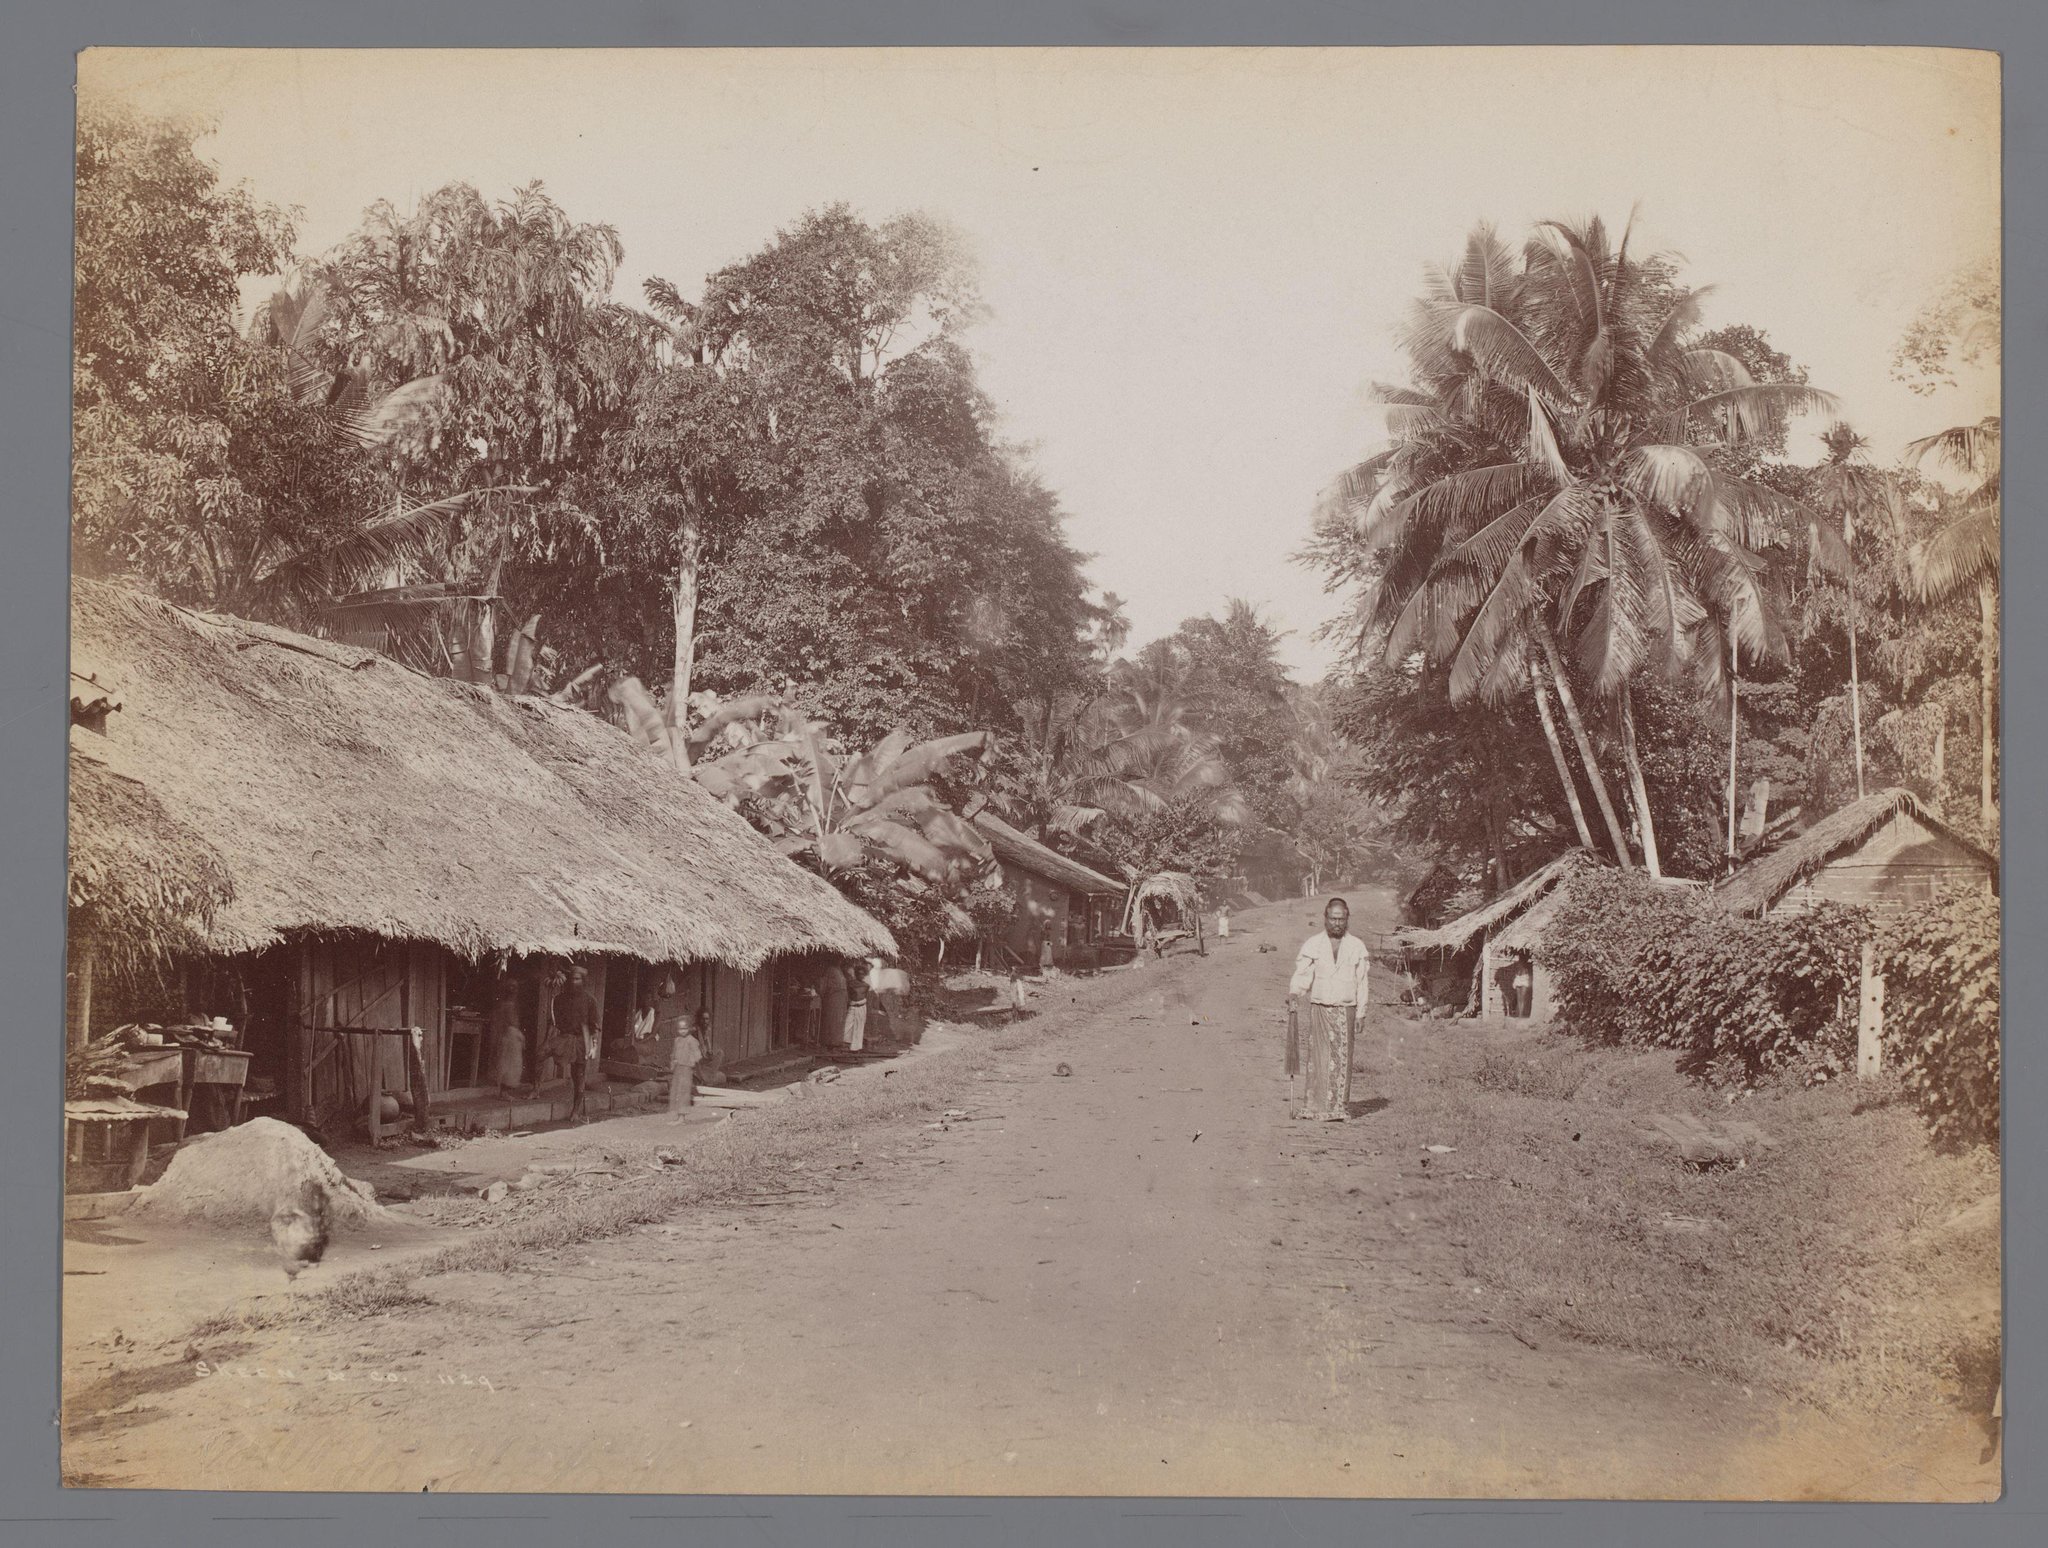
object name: photograph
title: Veyangoda, Sri Lanka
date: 1870-1900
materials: paper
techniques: albumen print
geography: sri lanka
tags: sri lanka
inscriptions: name: ‘Skeen & Co.’, number: ‘1129’, caption: ‘Veangoda’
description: Straat met rietbedekte huizen aan weerszijden en een poserende man met paard en opgevouwen paraplu.